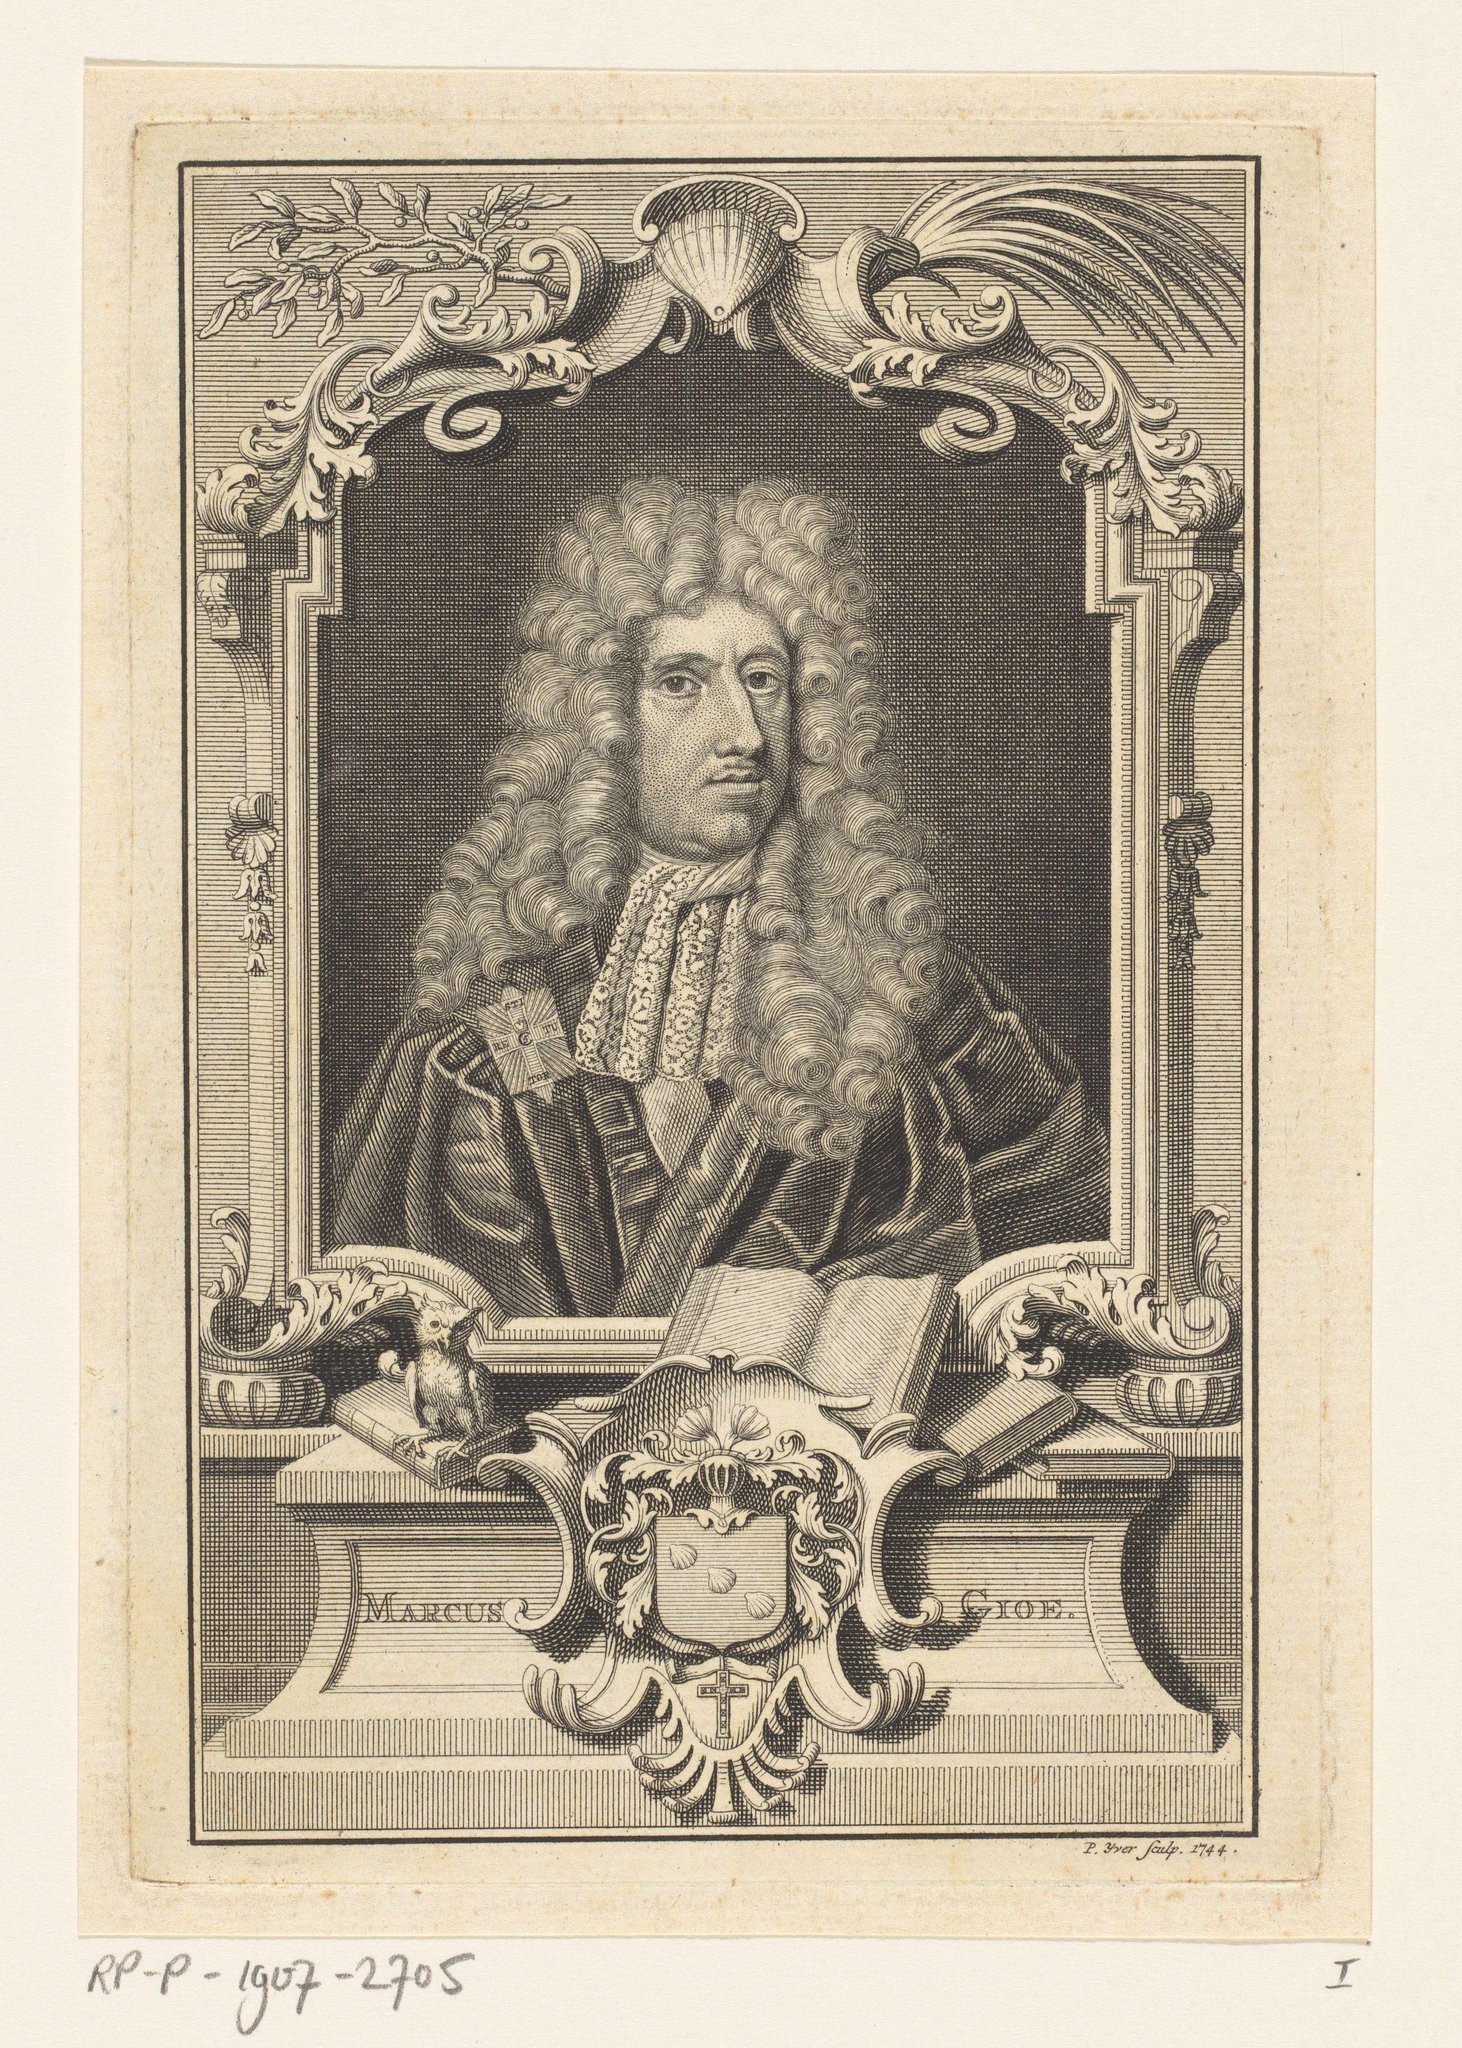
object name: print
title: Portret van Marcus Giöe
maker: pieter yver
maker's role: print maker, publisher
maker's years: 1712-1787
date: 1744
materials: paper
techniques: engraving, etching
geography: amsterdam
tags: marcus giöe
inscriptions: collector's mark: Lugt 1731, collector's mark: Lugt 2228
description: Portret van Marcus Giöe, Deens ambassadeur in Engeland, gevat in een ornamentele lijst. Onder het portret boeken en een uil, als symbool voor wijsheid. Midden onder zijn wapenschild.